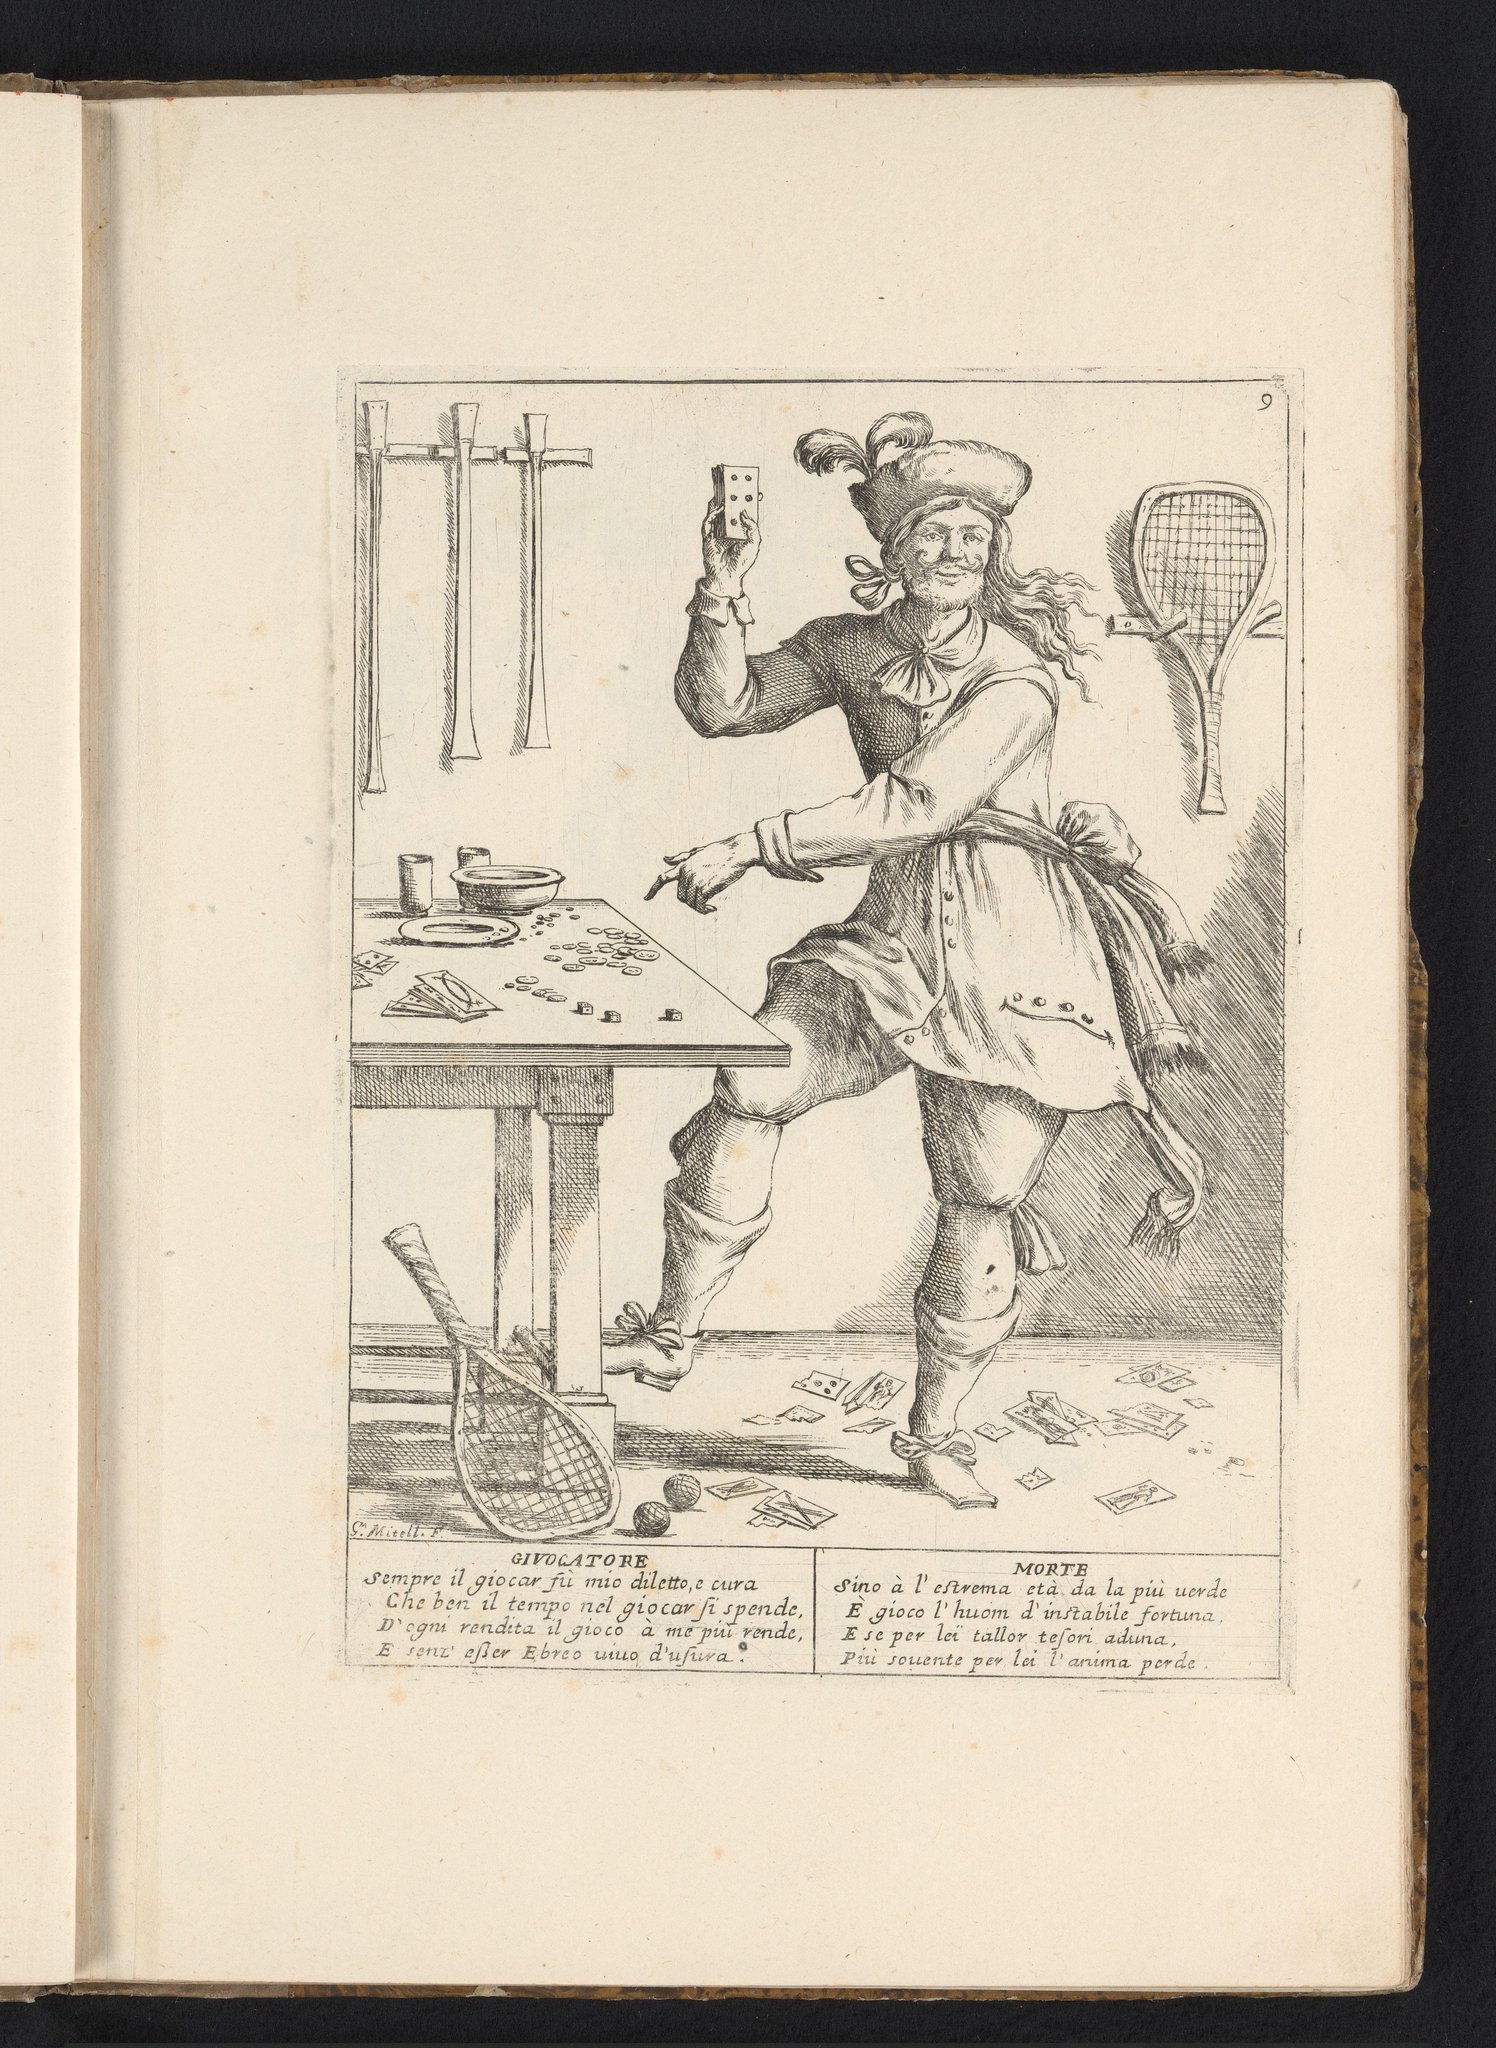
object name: print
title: De goklustige man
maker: giuseppe maria mitelli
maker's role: draughtsman, painter, print maker, publisher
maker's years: 1634-1718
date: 1675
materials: paper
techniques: engraving, etching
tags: betting, card-sharp, tennis, lawn-tennis (+ equipment, outfit (sports, games, etc.)), scenes symbolizing 'vanitas', the 24 hours of day and night, dice, playing-cards, personifications ~ the life of man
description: Een goklustige jonge man (Giuocatore) staande naast een tafel waarop speelkaarten, dobbelstenen en geldstukken liggen. Op de vloer meer kaarten en een tennisracket en twee ballen. Aan de wand de andere tennisracket. Met twee vierregelige verzen in het Italiaans. Genummerd rechtsboven: 9. Onderdeel van de serie 'De vierentwintig uren van het menselijk geluk'.